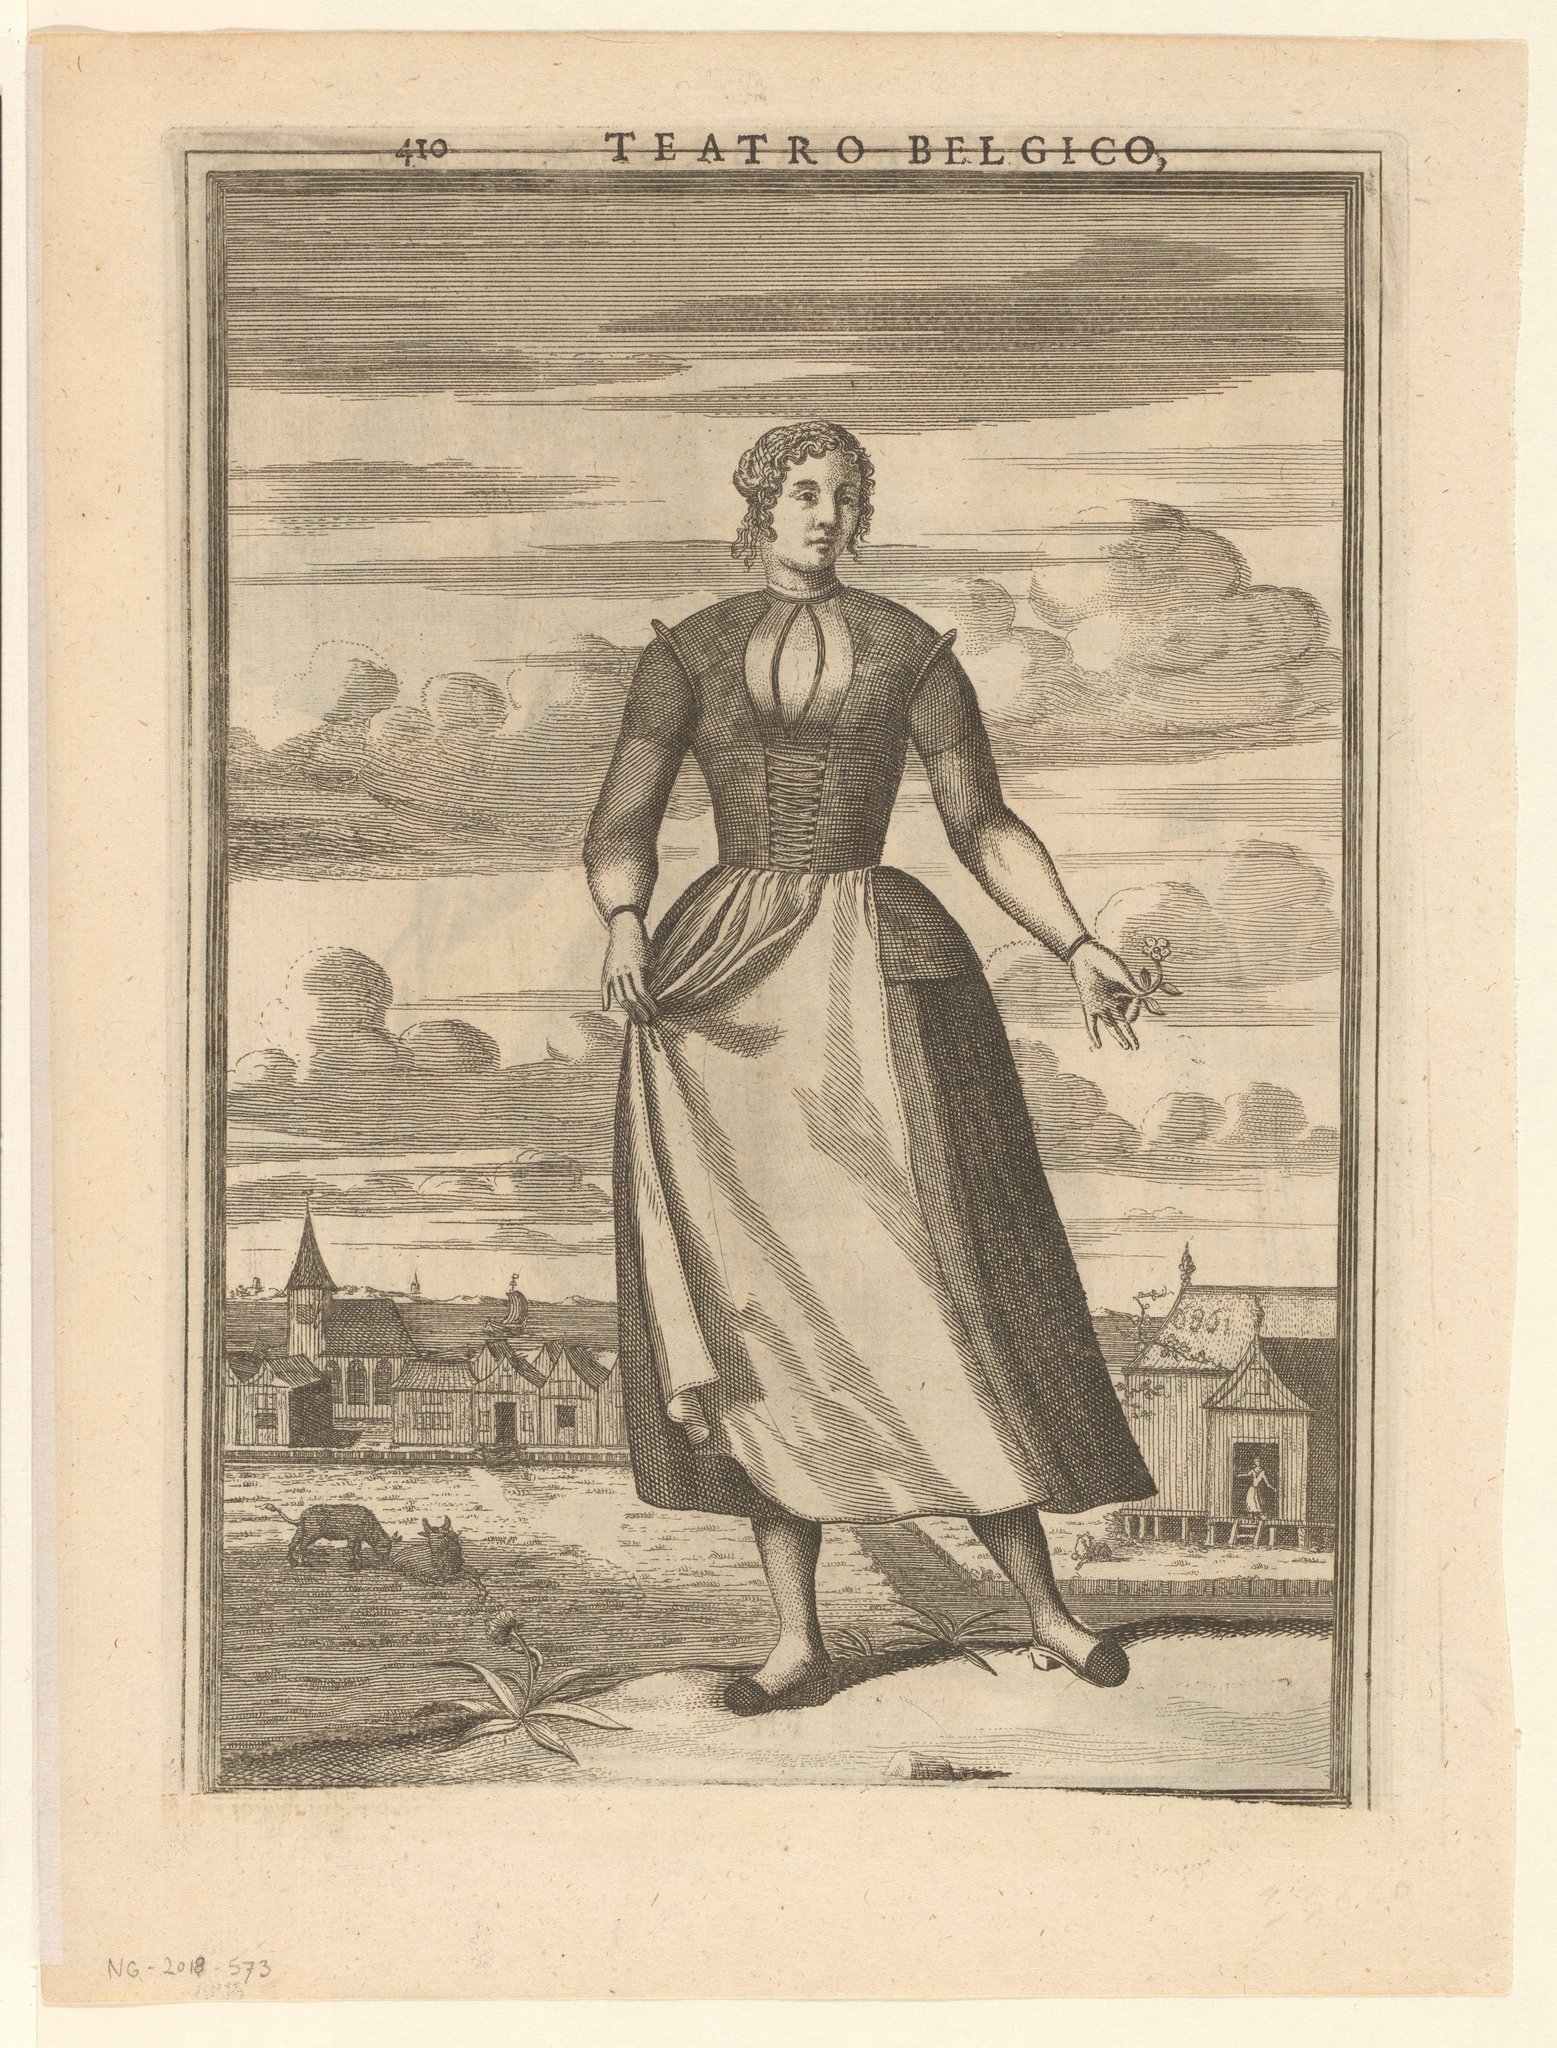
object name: print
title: Hollandse vrouw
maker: Anonymous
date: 1690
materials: paper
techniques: engraving, etching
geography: netherlands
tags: meadow, pasture, village, folk costume, regional costume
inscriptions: inscription: ‘410 Teatro Belgico,’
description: Hollandse vrouw in lange rok met schort, staande aan de rand van een weiland, op de achtergrond de gebouwen van een kustdorp. De prent verscheen in het Italiaanstalige werk van Gregorio Leti, 'Teatro Belgico, o vero ritratti historici, chronologici, politici e geografici, delle Sette Provincie Unite' (Amsterdam 1690).